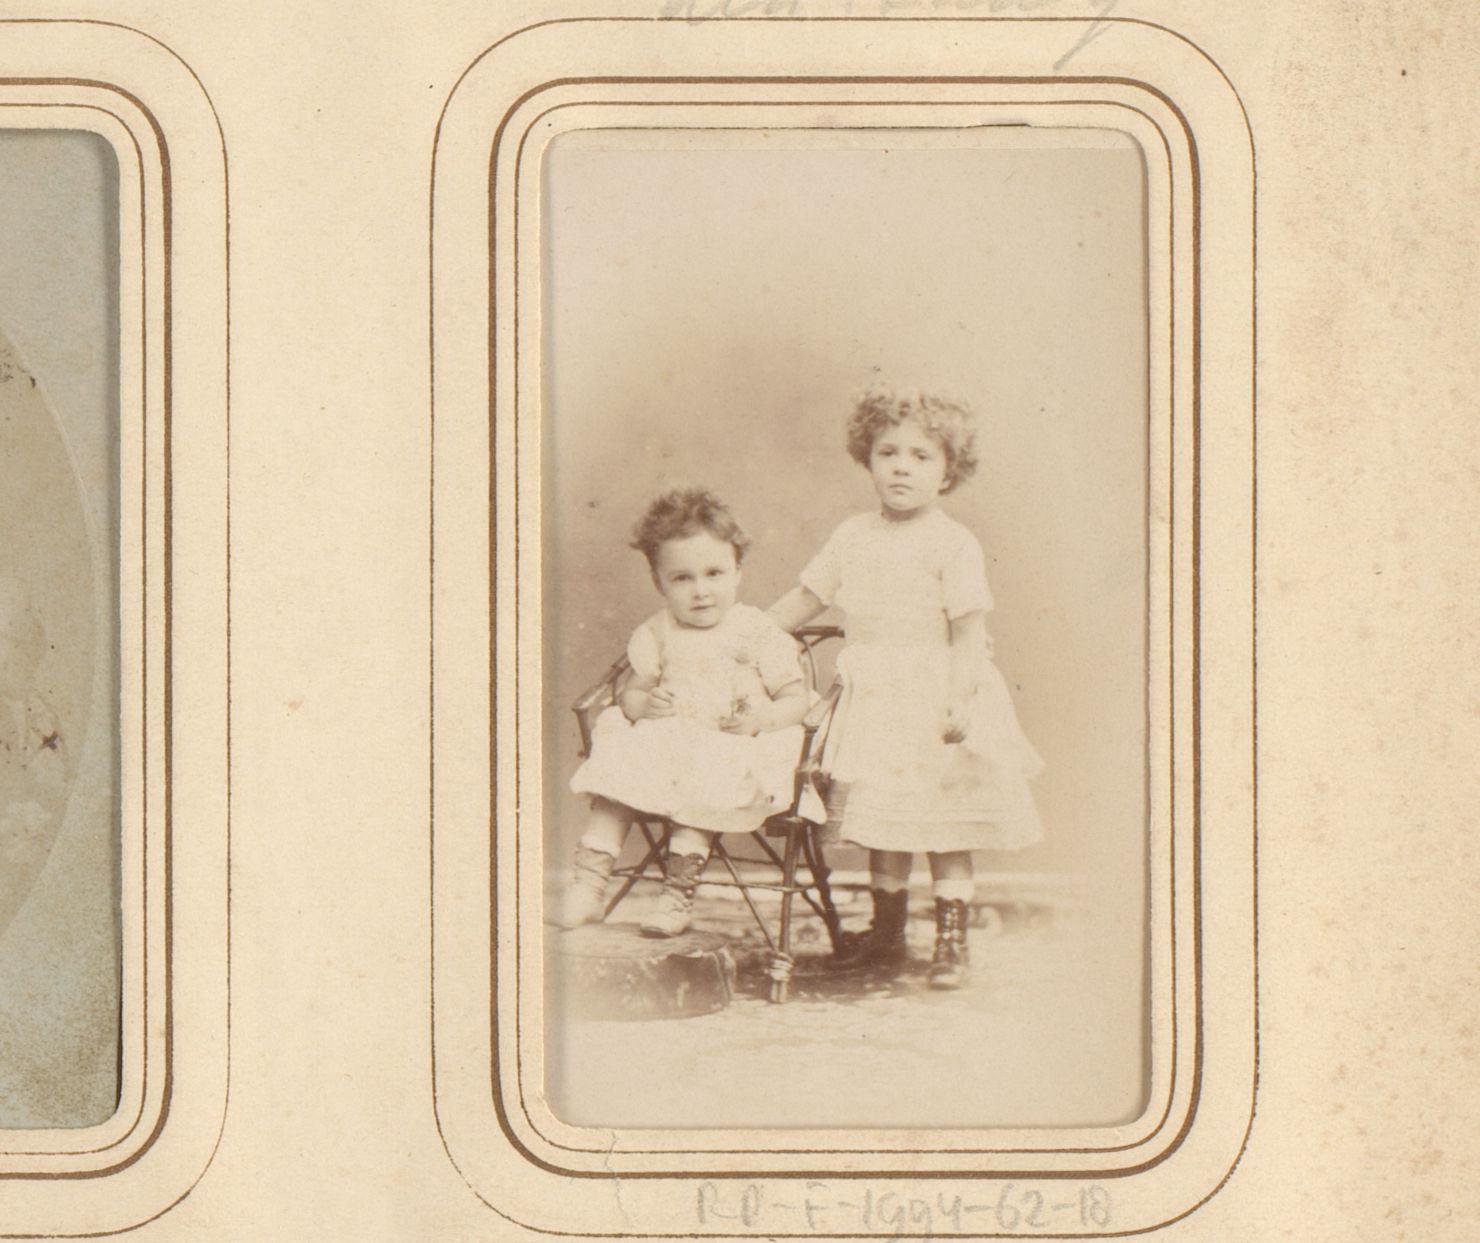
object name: album leaf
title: Portret van twee kinderen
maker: wilhelm j. grammann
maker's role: fotograaf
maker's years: 1844-1874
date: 1860-1880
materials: cardboard, photographic support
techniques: albumen print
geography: the hague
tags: child, brothers or sisters (second degree family relationships)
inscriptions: inscription: ‘Kinderen van Adelberth en M C du Quesne?’, inscription: ‘W.J. Grammann 's Hage’, inscription: ‘W.J. Grammann / 's Hage / 12 / Willemstraat / 12/ Voor nabestellingen worden de origineelplaten bewaard.’